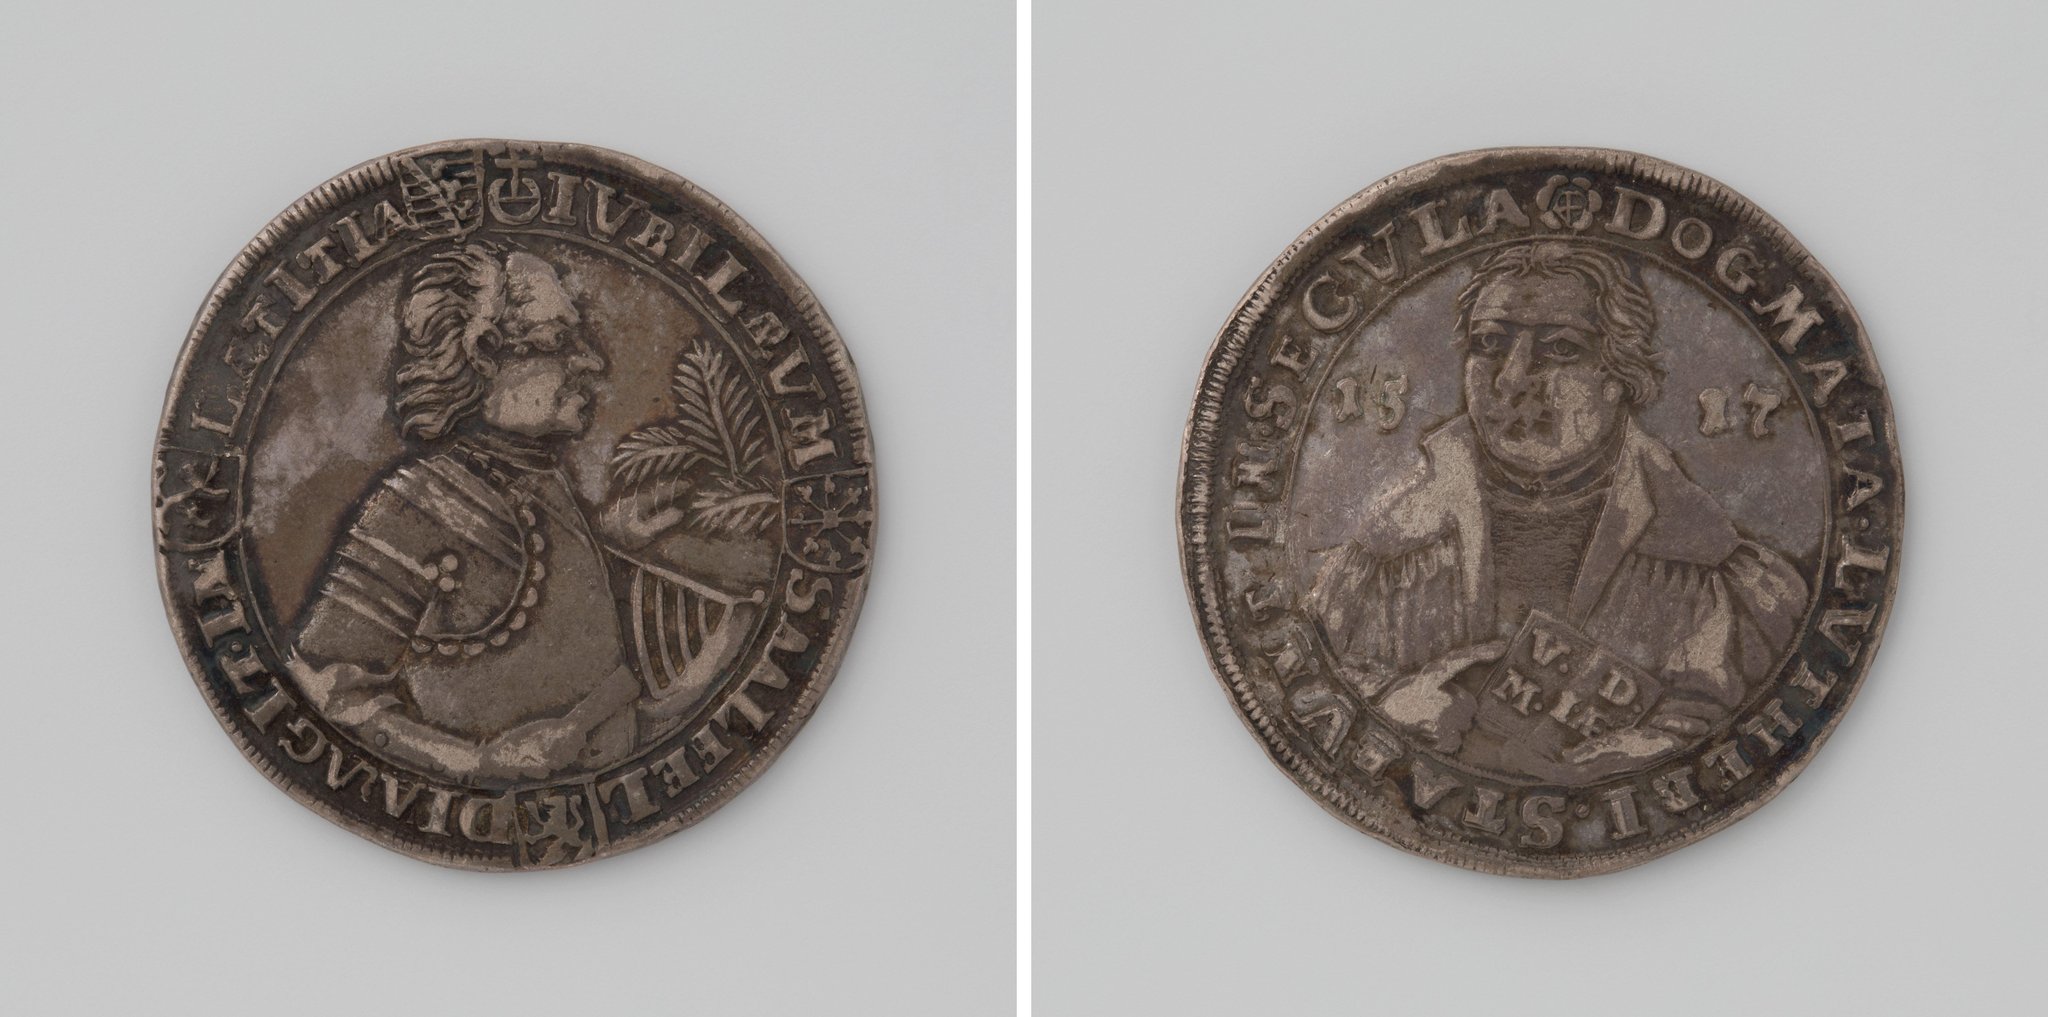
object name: history medal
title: Herdenkingsdaalder tweede eeuwfeest van de Reformatie, te Saalfelden gevierd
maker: Anonymous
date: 1717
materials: silver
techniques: striking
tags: martin luther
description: Zilveren penning. Voorzijde: borststuk man met helm in de hand binnen omschrift onderbroken door vier wapenschilden. Keerzijde: borststuk man met bijbel in hand binnen omschrift